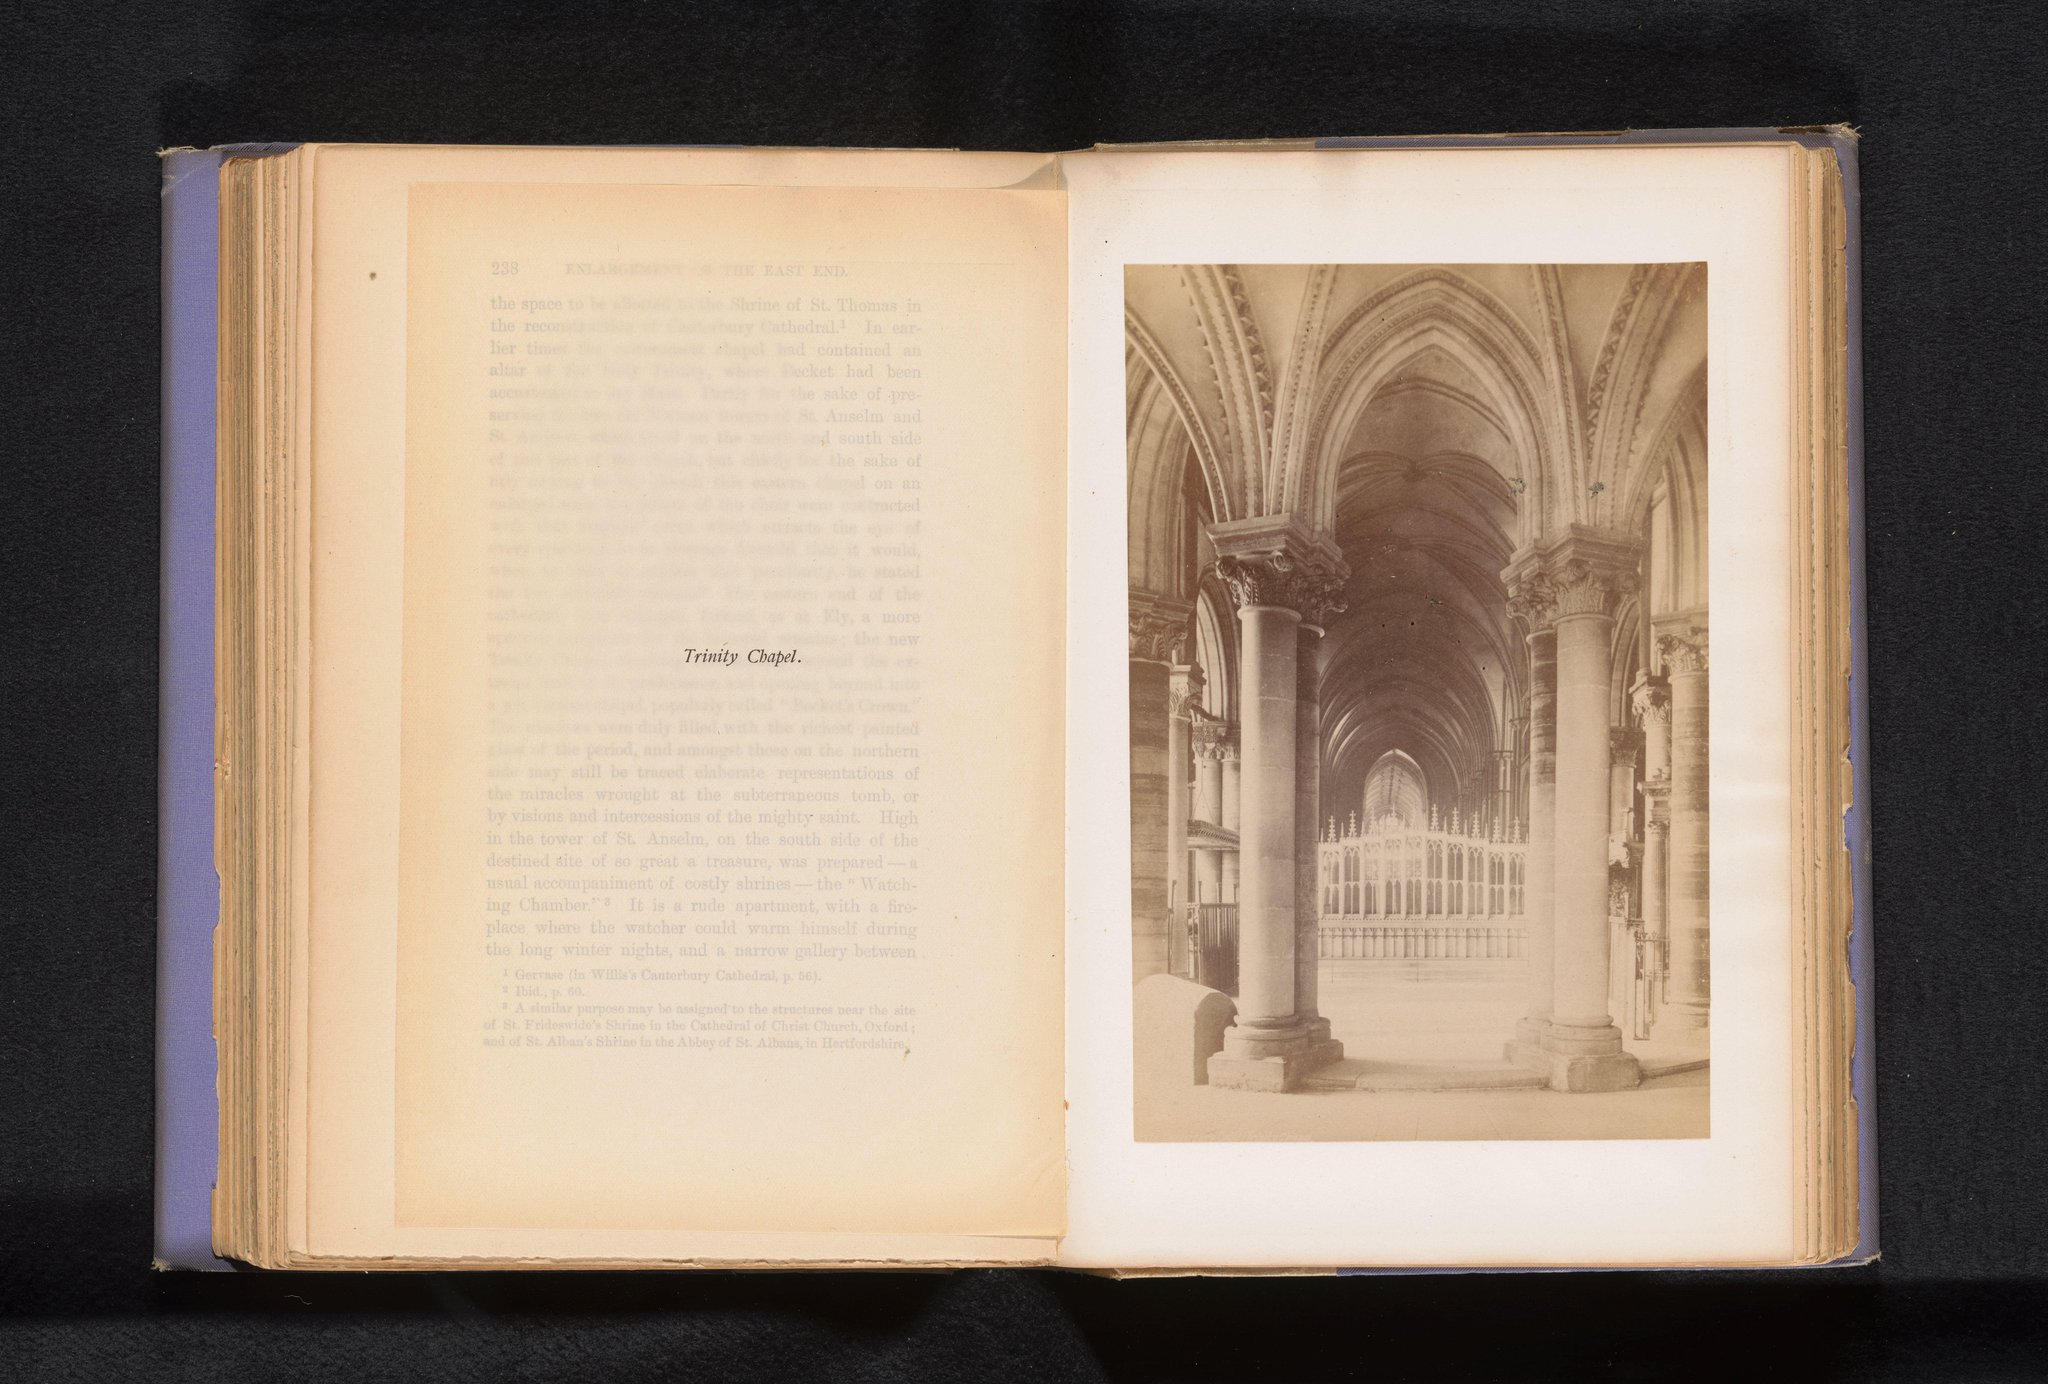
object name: photograph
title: Interieur van de Trinity Chapel in de kathedraal van Canterbury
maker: Anonymous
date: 1882-1892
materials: photographic support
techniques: albumen print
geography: canterbury cathedral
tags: parts of church interior: chapel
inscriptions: inscription: ‘Canterbury [...]’